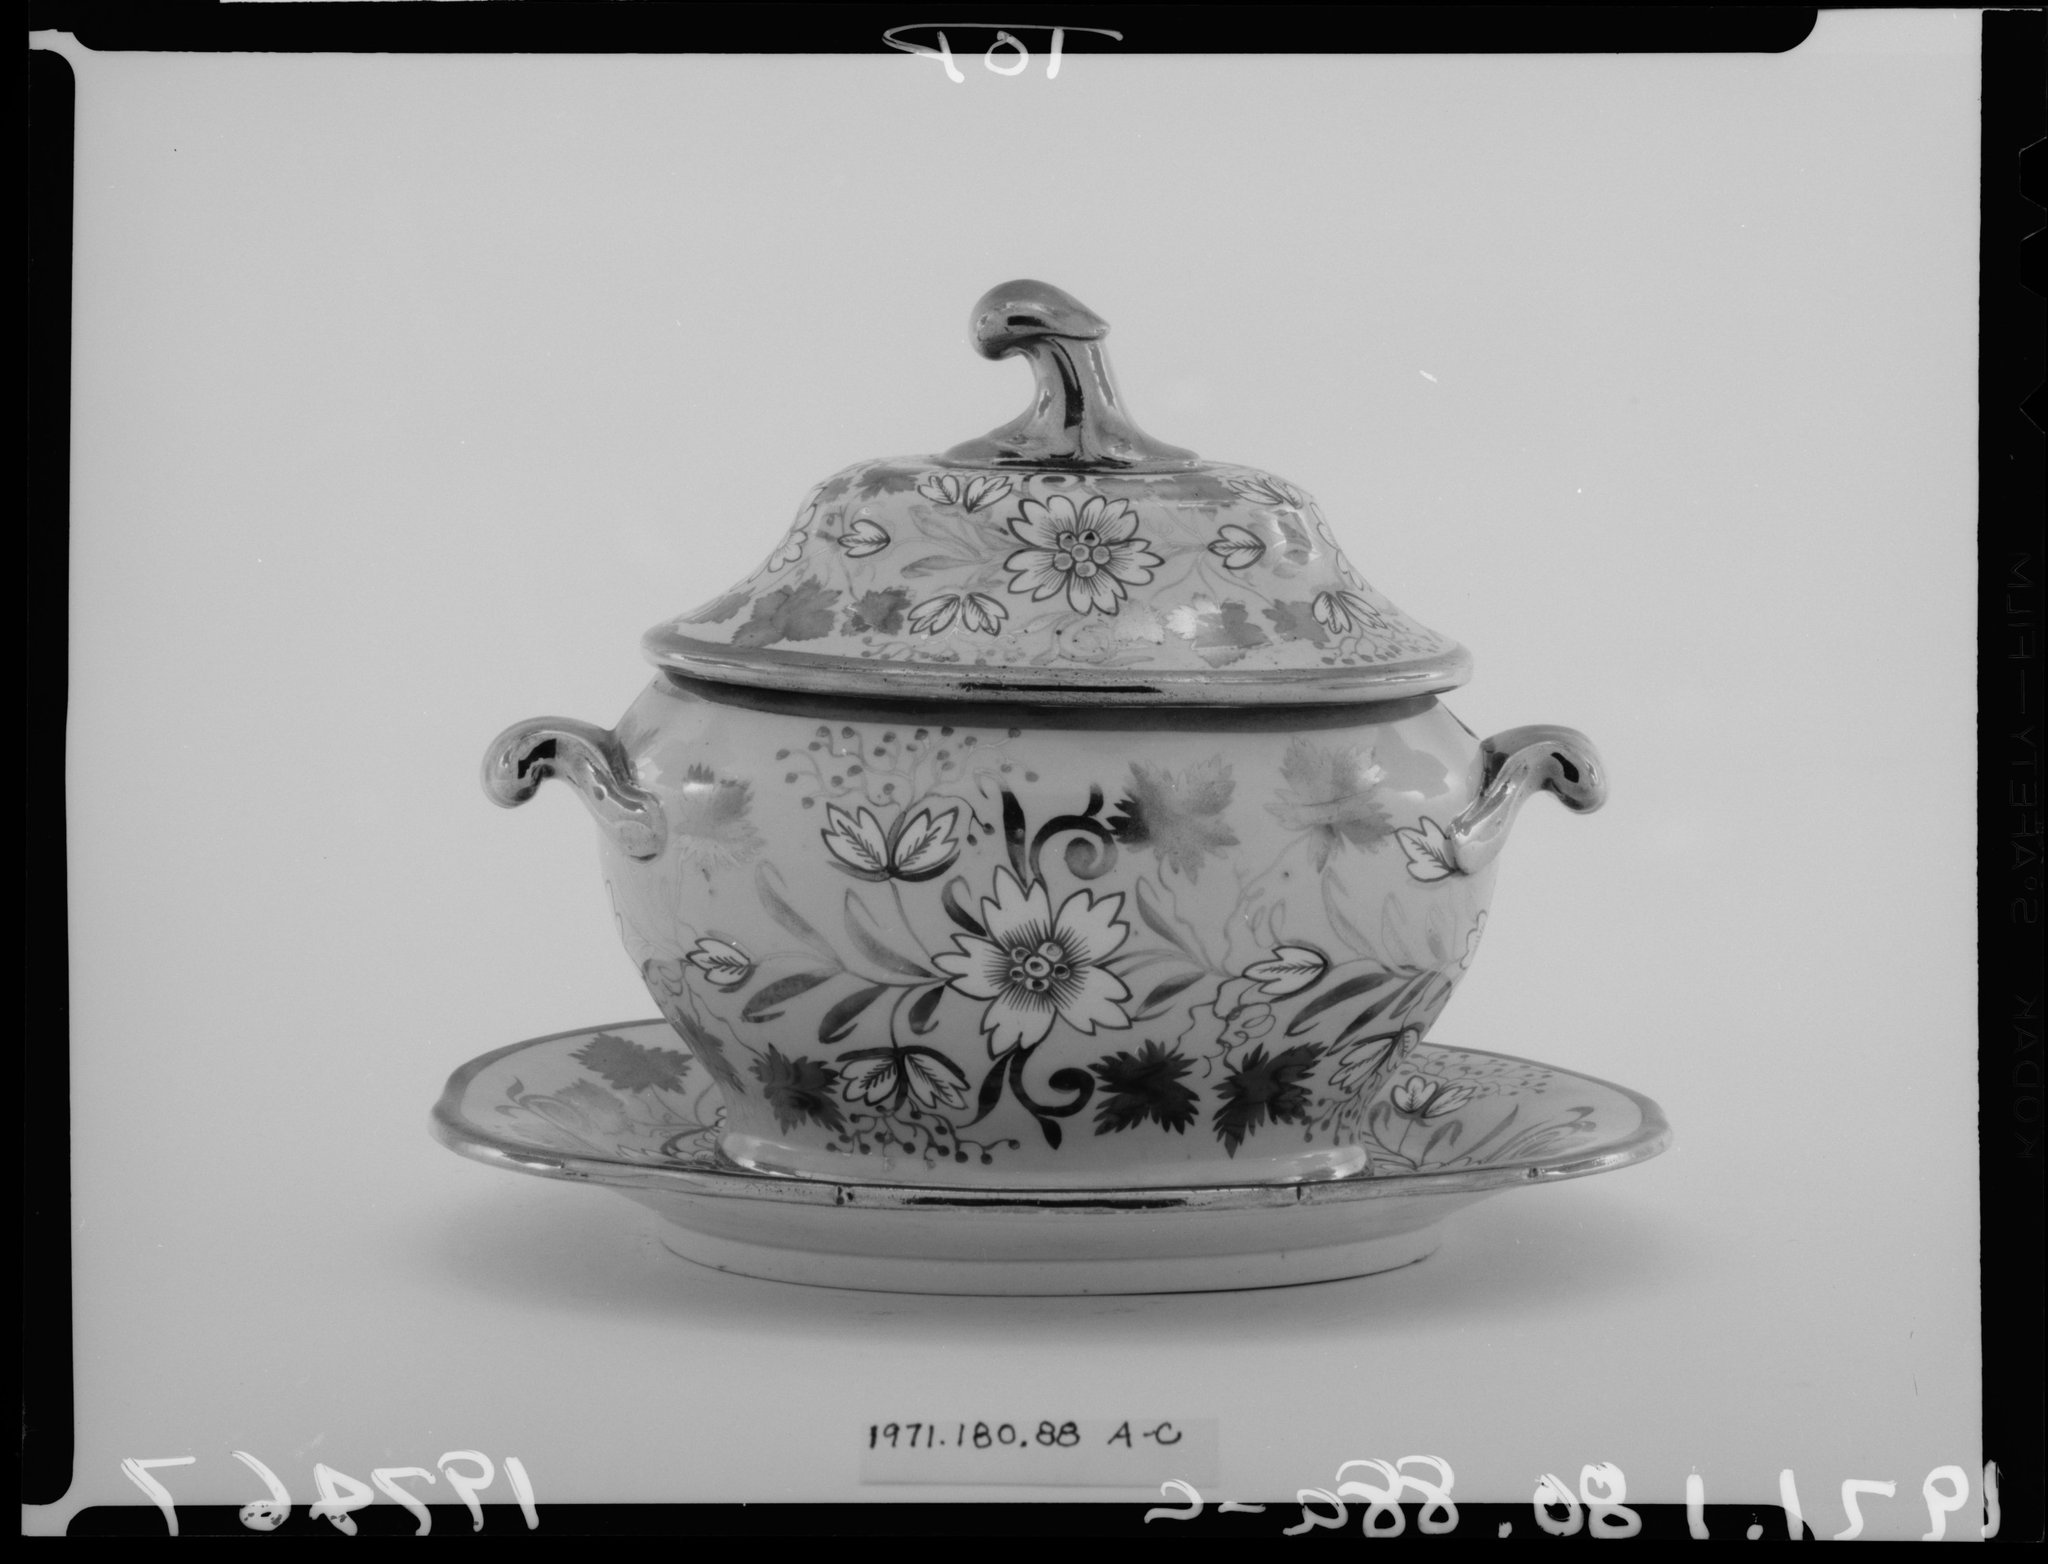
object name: sauce tureen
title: Covered Sauce Tureen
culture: british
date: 1835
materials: earthenware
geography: england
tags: flowers